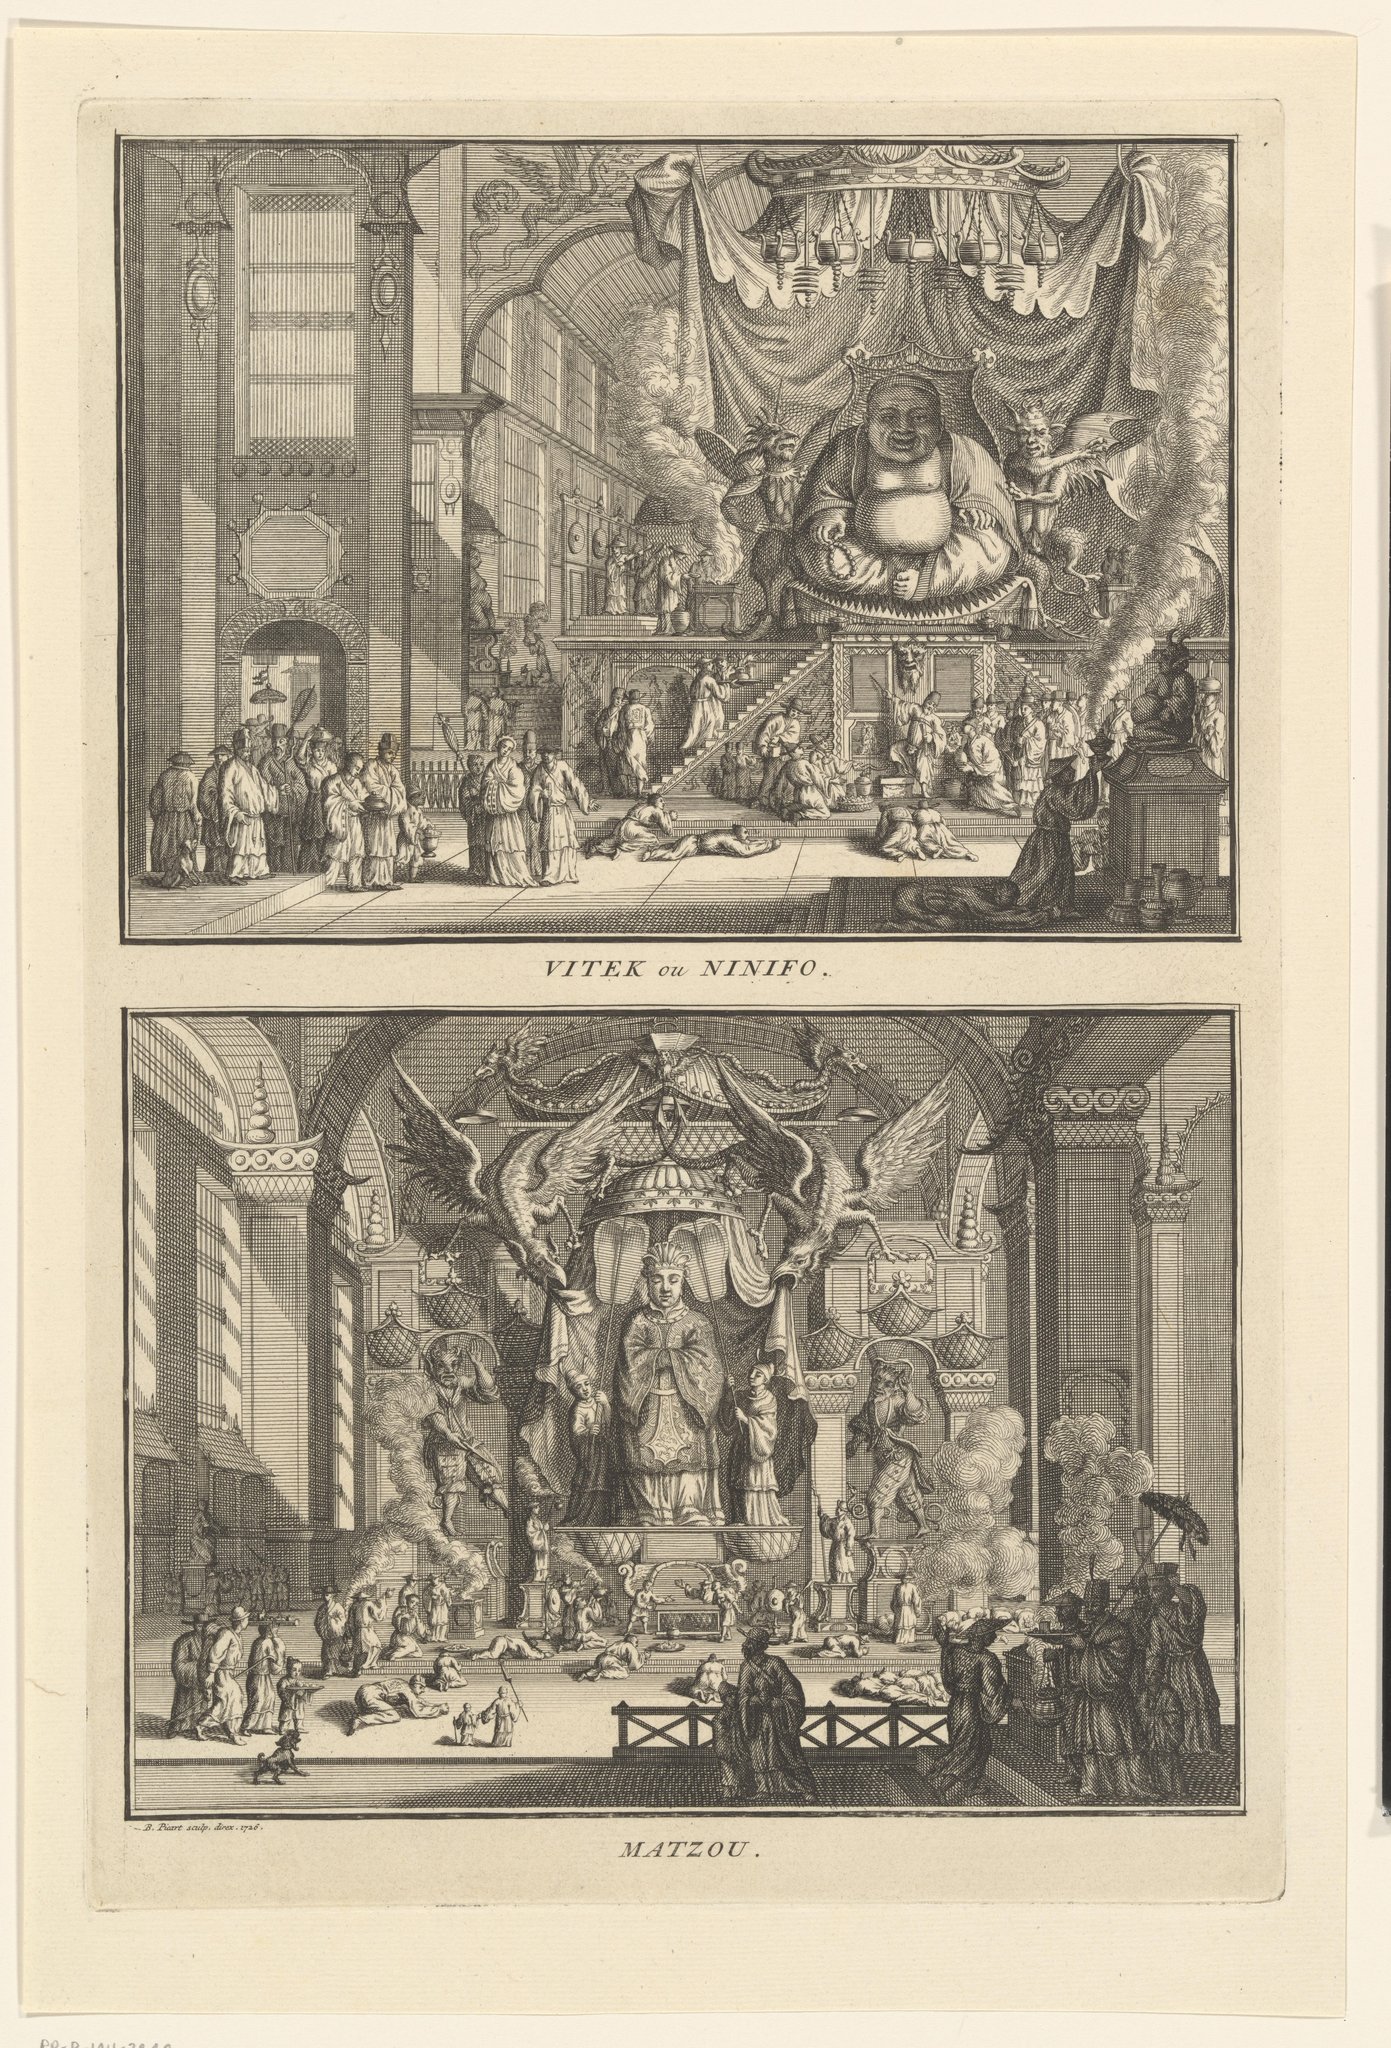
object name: book illustration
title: Statues of Chinese Deities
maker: bernard picart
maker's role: draughtsman, print maker, publisher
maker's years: 1673-1733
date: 1726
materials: paper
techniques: engraving, etching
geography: amsterdam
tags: conceptions and ideas visualized ~ traditional chinese religions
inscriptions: collector's mark: Lugt 2228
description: In this print, Picart depicts Chinese deities and ceremonies in a decorative, theatrical style, reminiscent of the European Baroque. The top image features a chubby Laughing Buddha known as Maitreya (Milefo). At the bottom, we see the Chinese sea goddess Mazu. Both idols are seated on elevated thrones and surrounded by guardians resembling demons. Kneeling devotees worship them with burning incense.